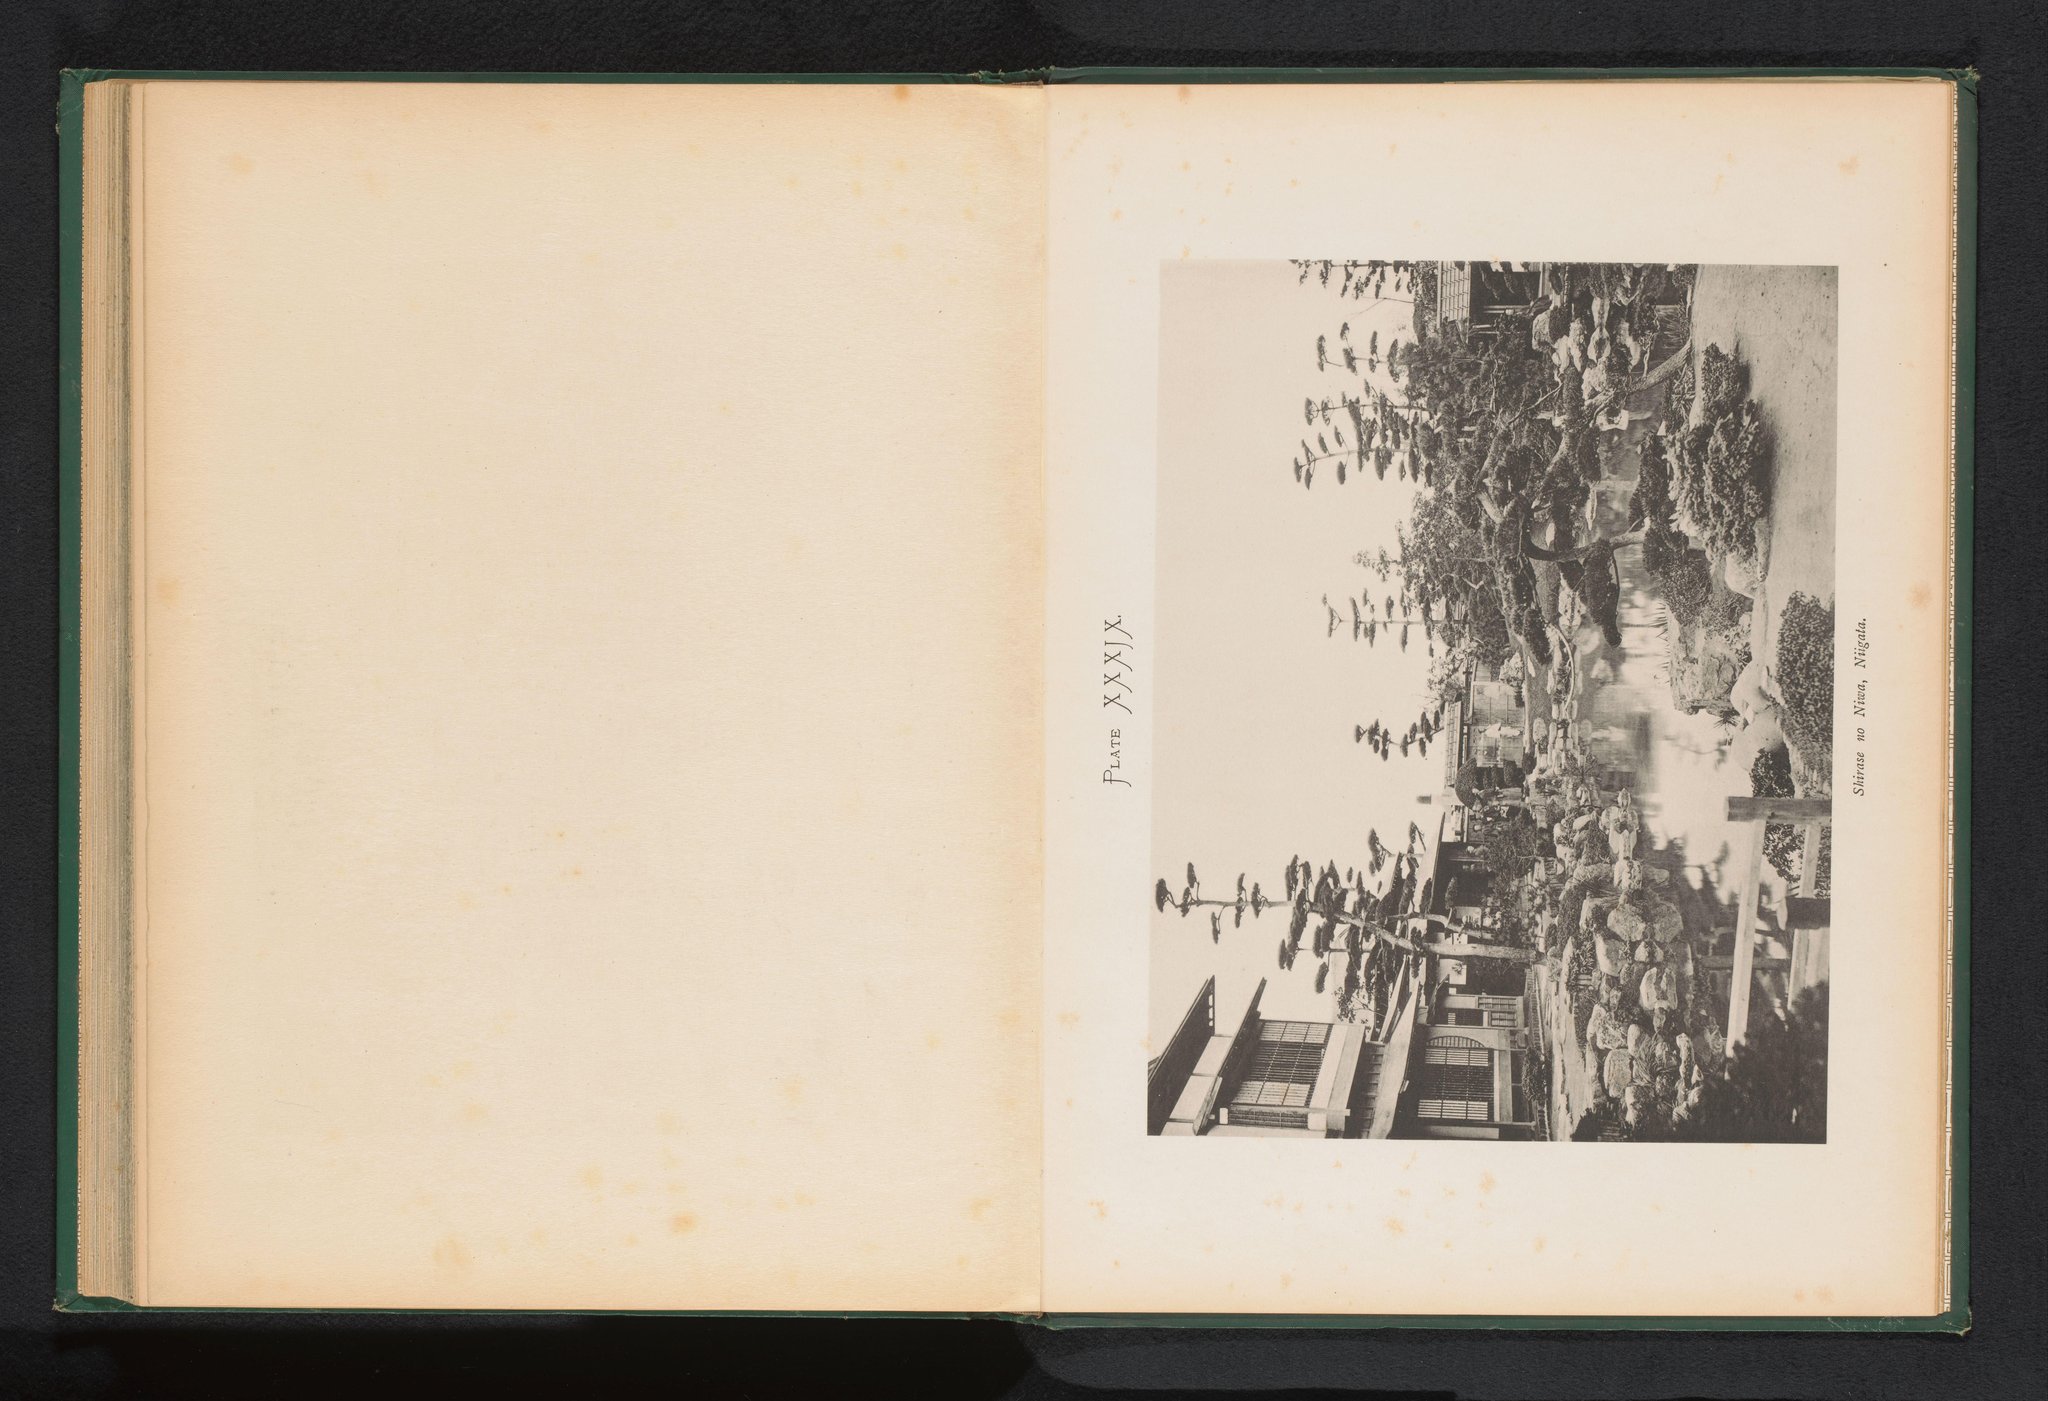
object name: page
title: Gezicht op de Shirase-no-Niwa in Niigata, Japan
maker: kazumasa ogawa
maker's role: auteur, fotograaf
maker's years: 1860-1929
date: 1888-1893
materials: paper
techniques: photograph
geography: niigata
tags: garden, pond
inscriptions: inscription: ‘Plate XXXIX.’